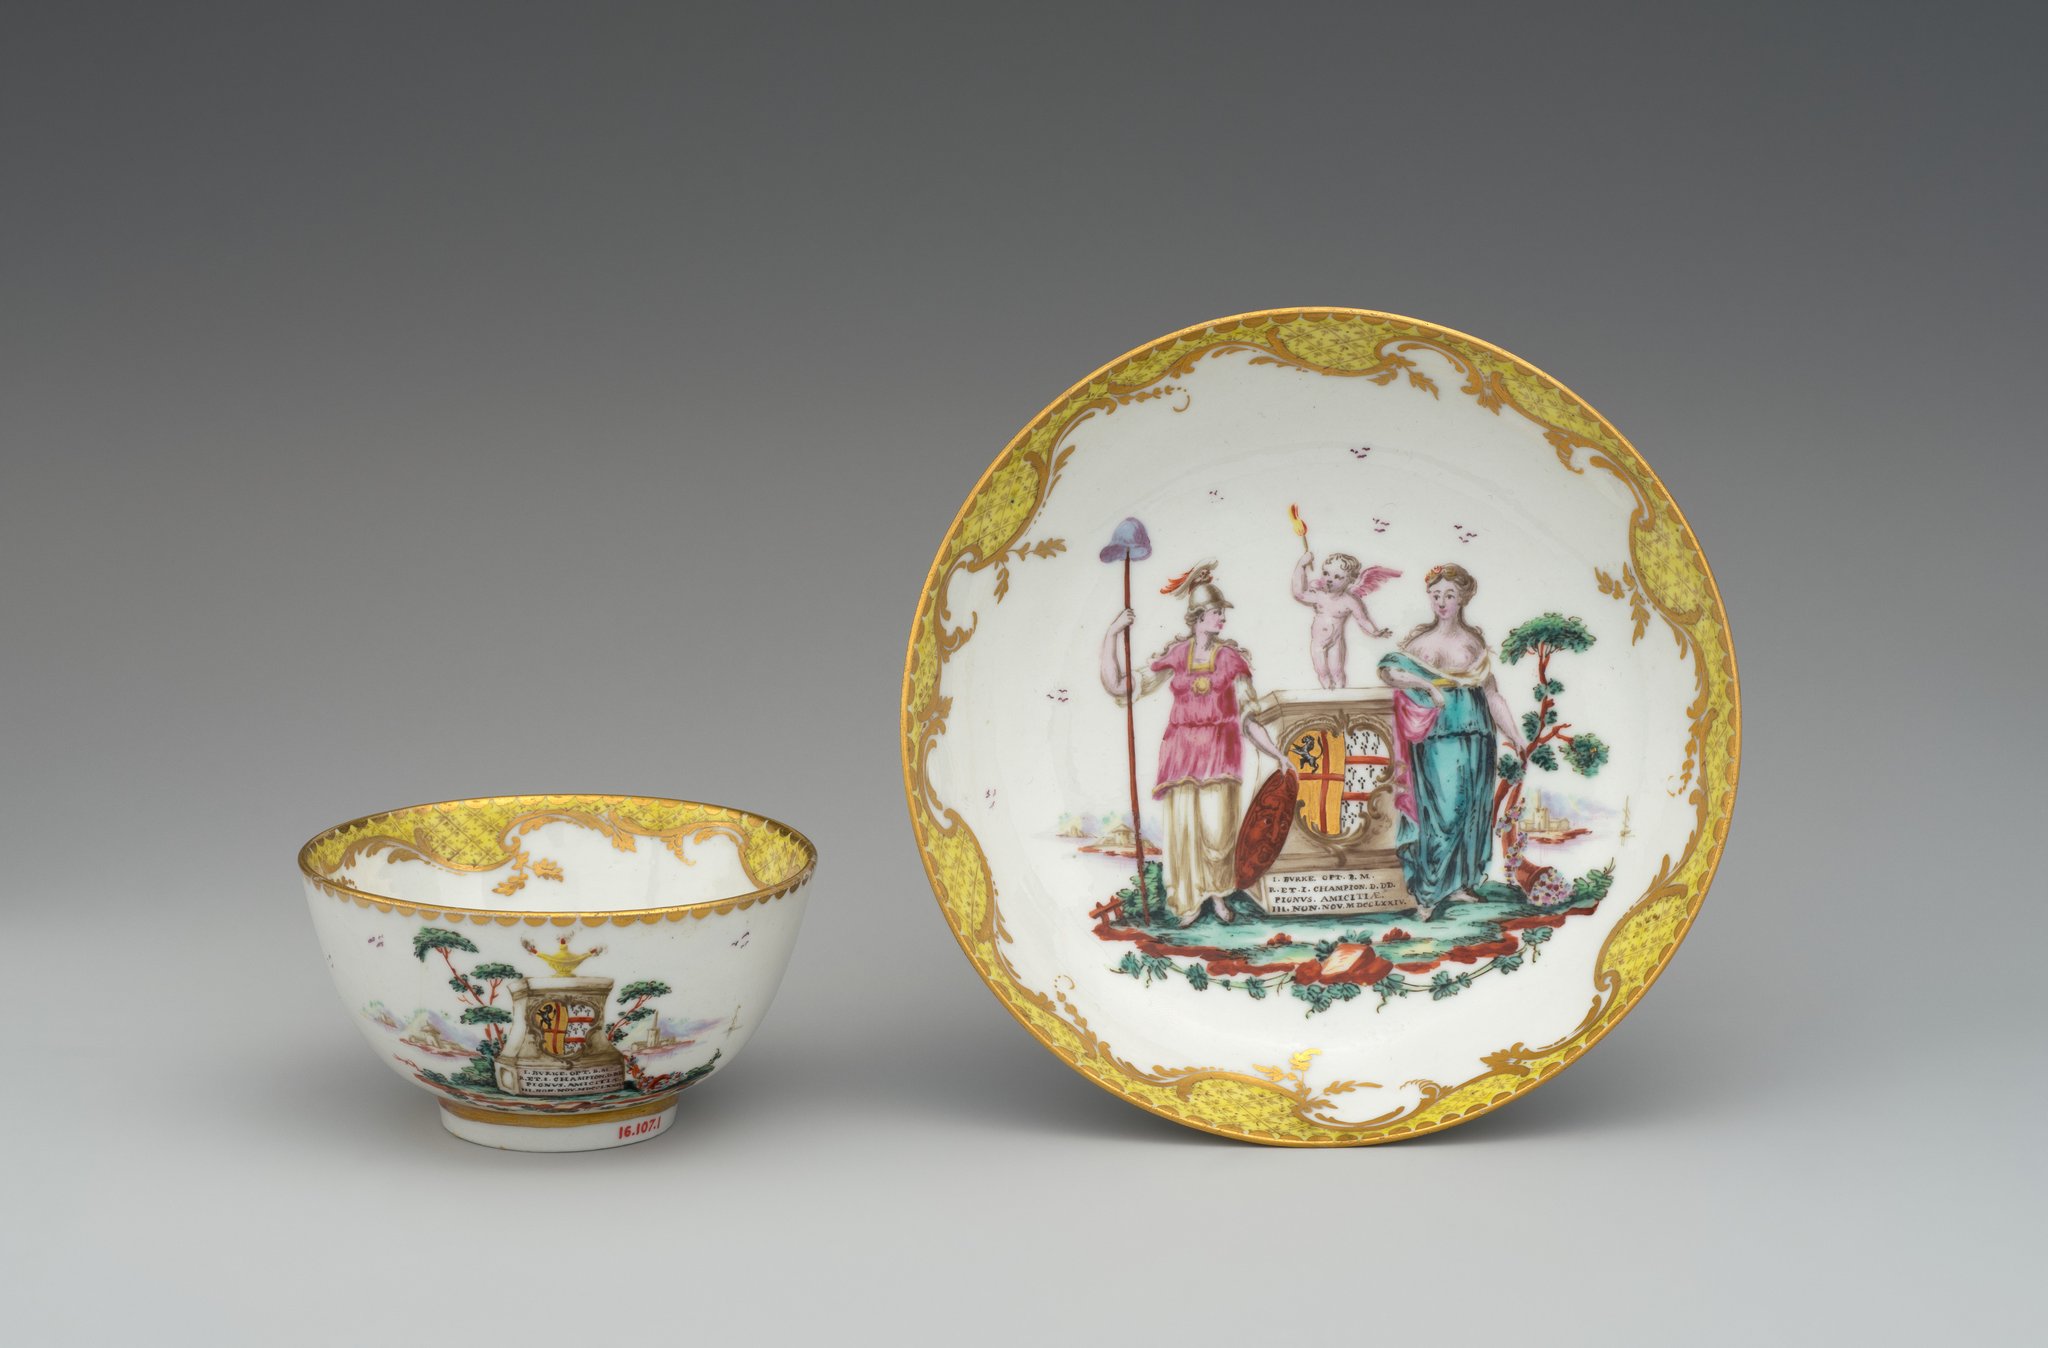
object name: cup and saucer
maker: bristol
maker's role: factory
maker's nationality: british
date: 1774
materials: hard paste porcelain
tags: coat of arms